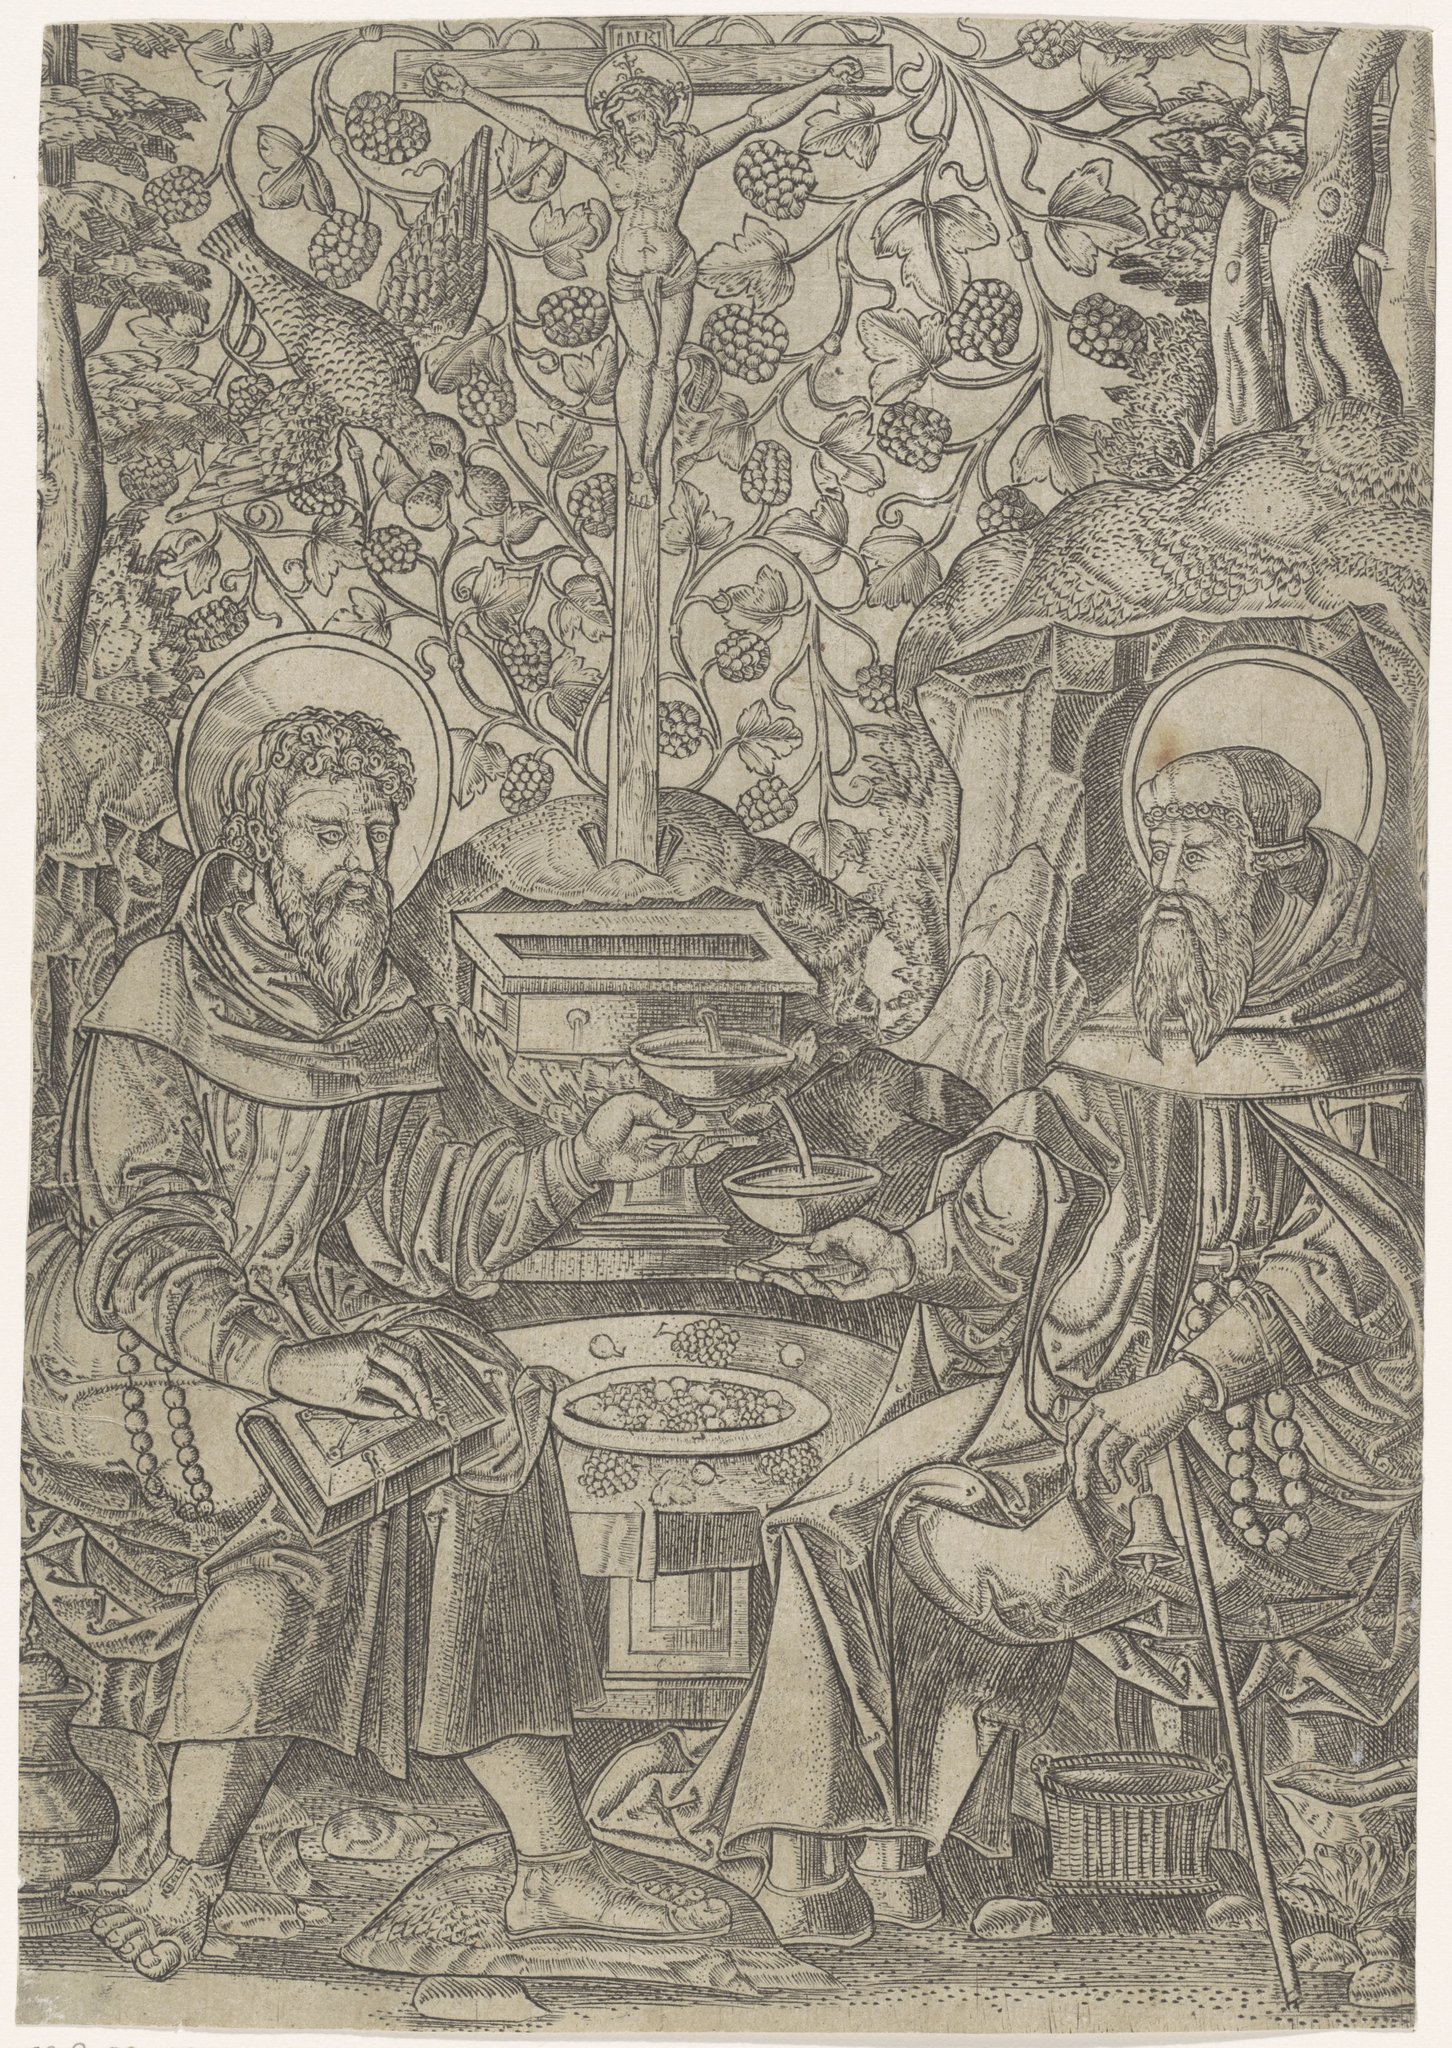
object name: print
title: Twee heiligen bij Christus als Fons Vitae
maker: Anonymous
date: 1530-1570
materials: paper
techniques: engraving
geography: low countries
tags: christ on the cross (in a fountain), shedding his blood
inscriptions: collector's mark: Lugt 2228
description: Het kruis van Christus boven een fontein (Fons Vitae) met tegen de achtergrond wijnranken. Twee heiligen, Antonius de Grote (Antonius Abt) en Paulus de kluizenaar, zitten op de voorgrond en houden hun bekers onder de fontein om het bloed van Christus als wijn op te vangen.